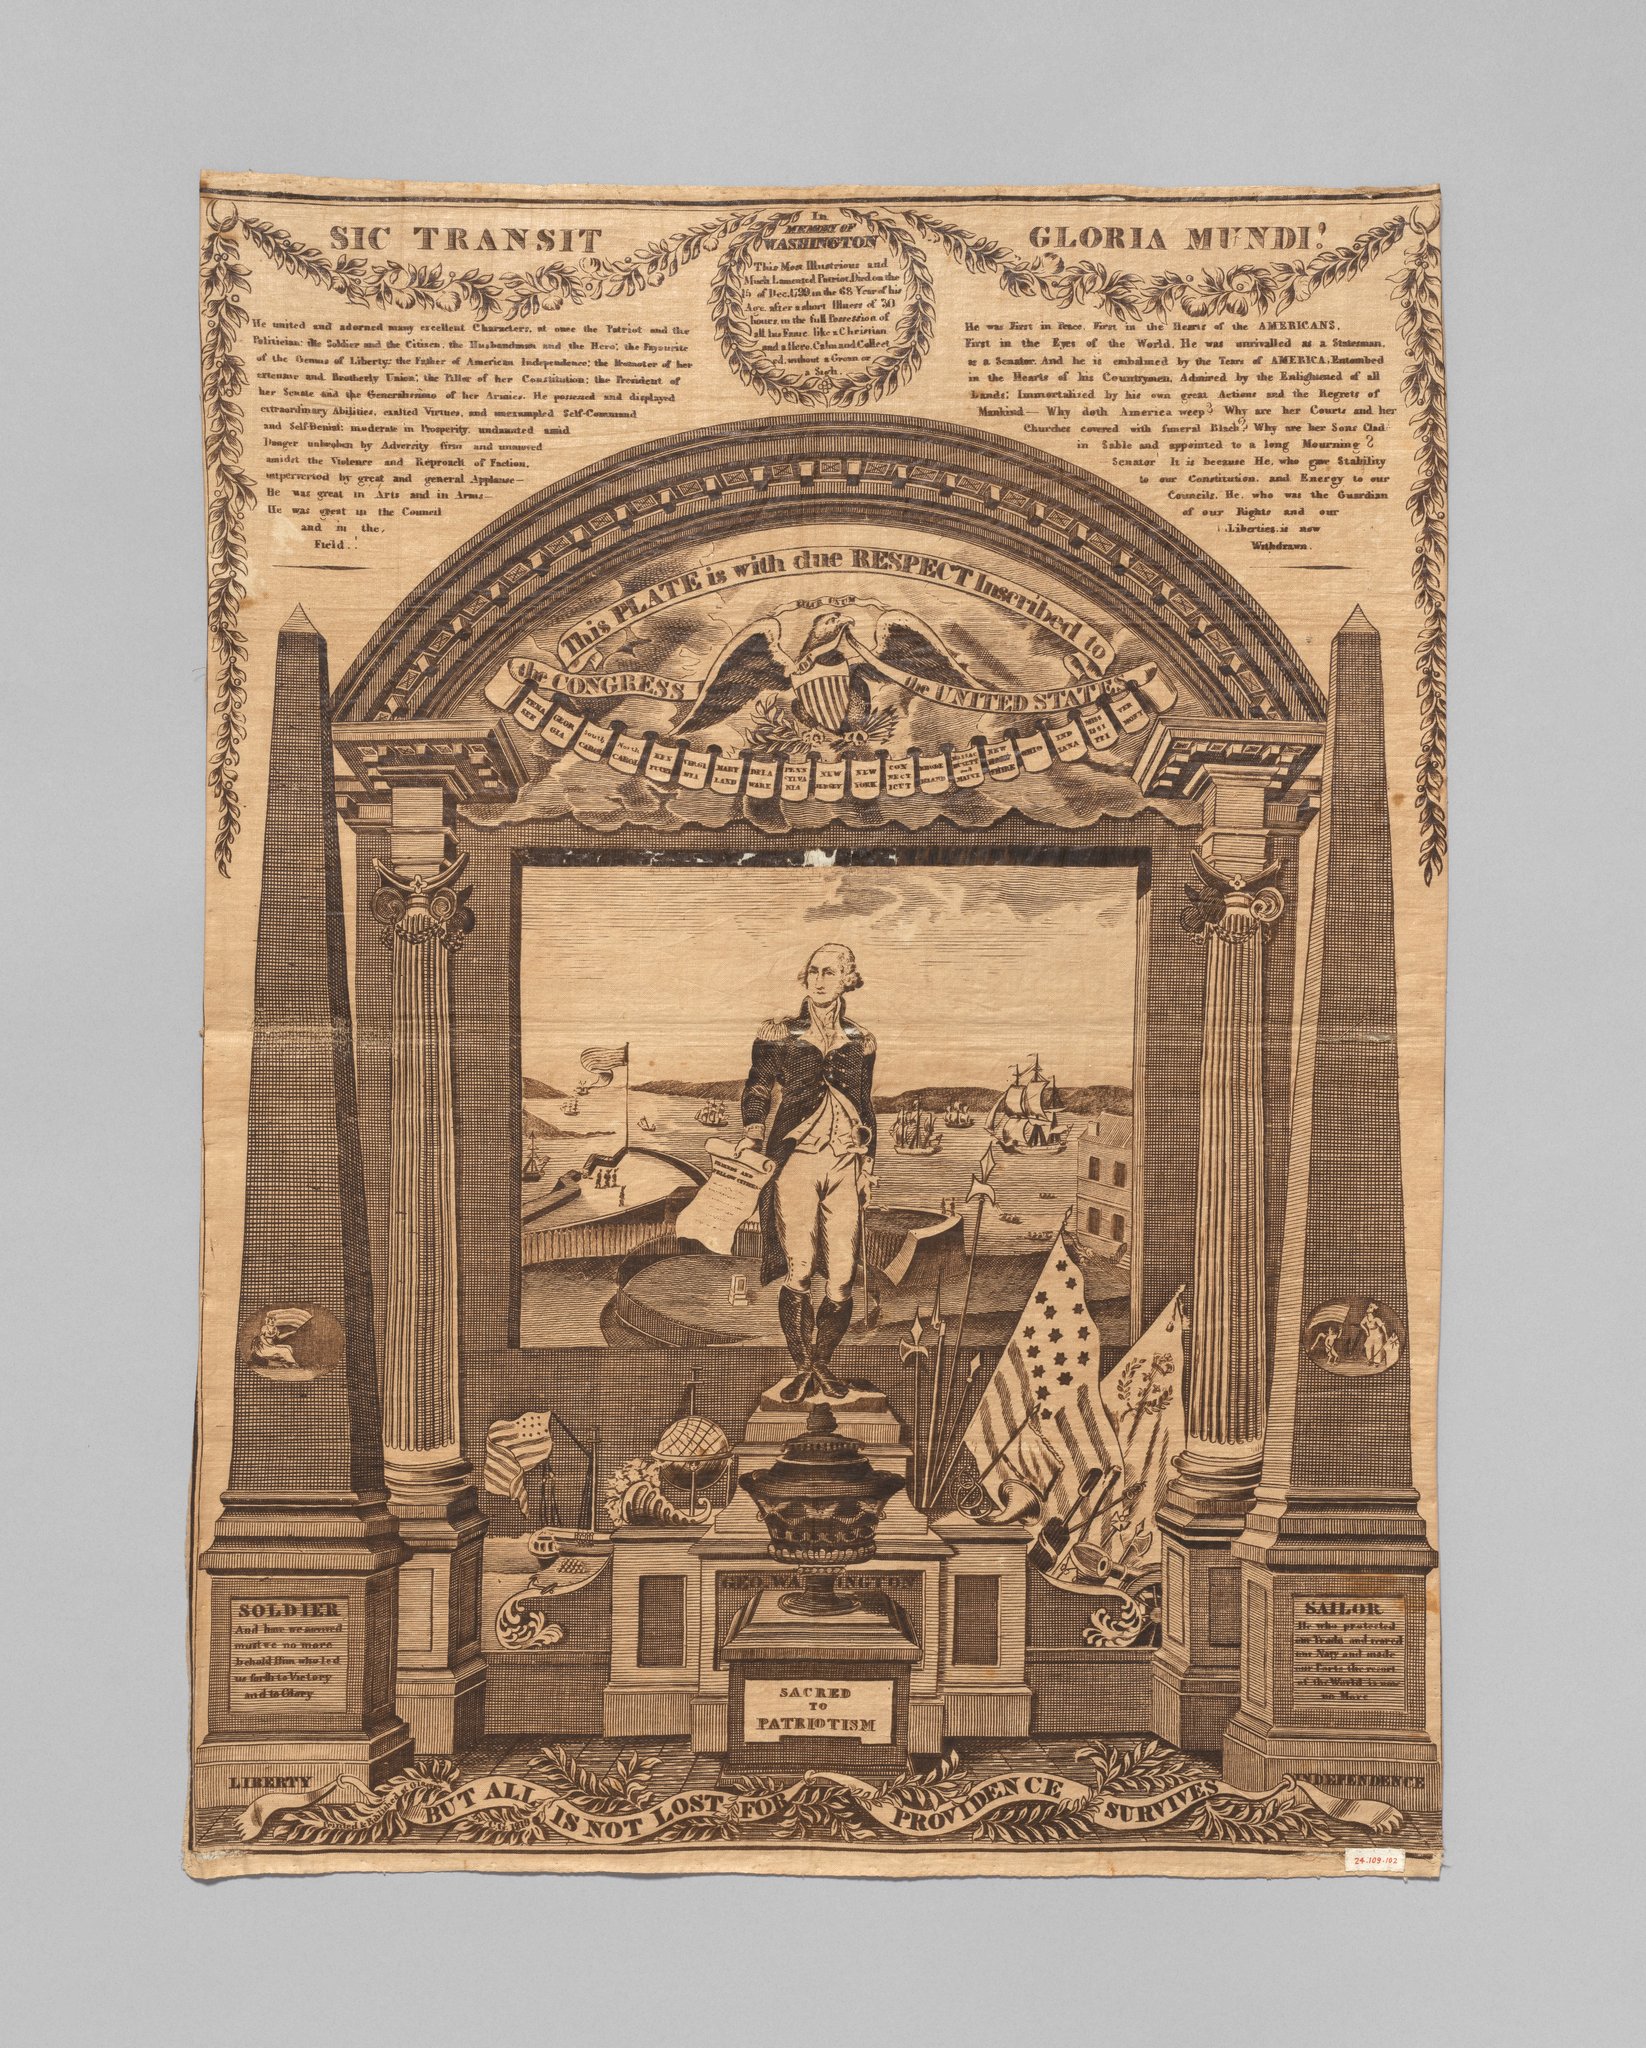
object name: handkerchief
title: Event handkerchief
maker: c.g. (probably colin gillespie)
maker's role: manufactory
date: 1819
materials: linen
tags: george washington,men,coat of arms,flags